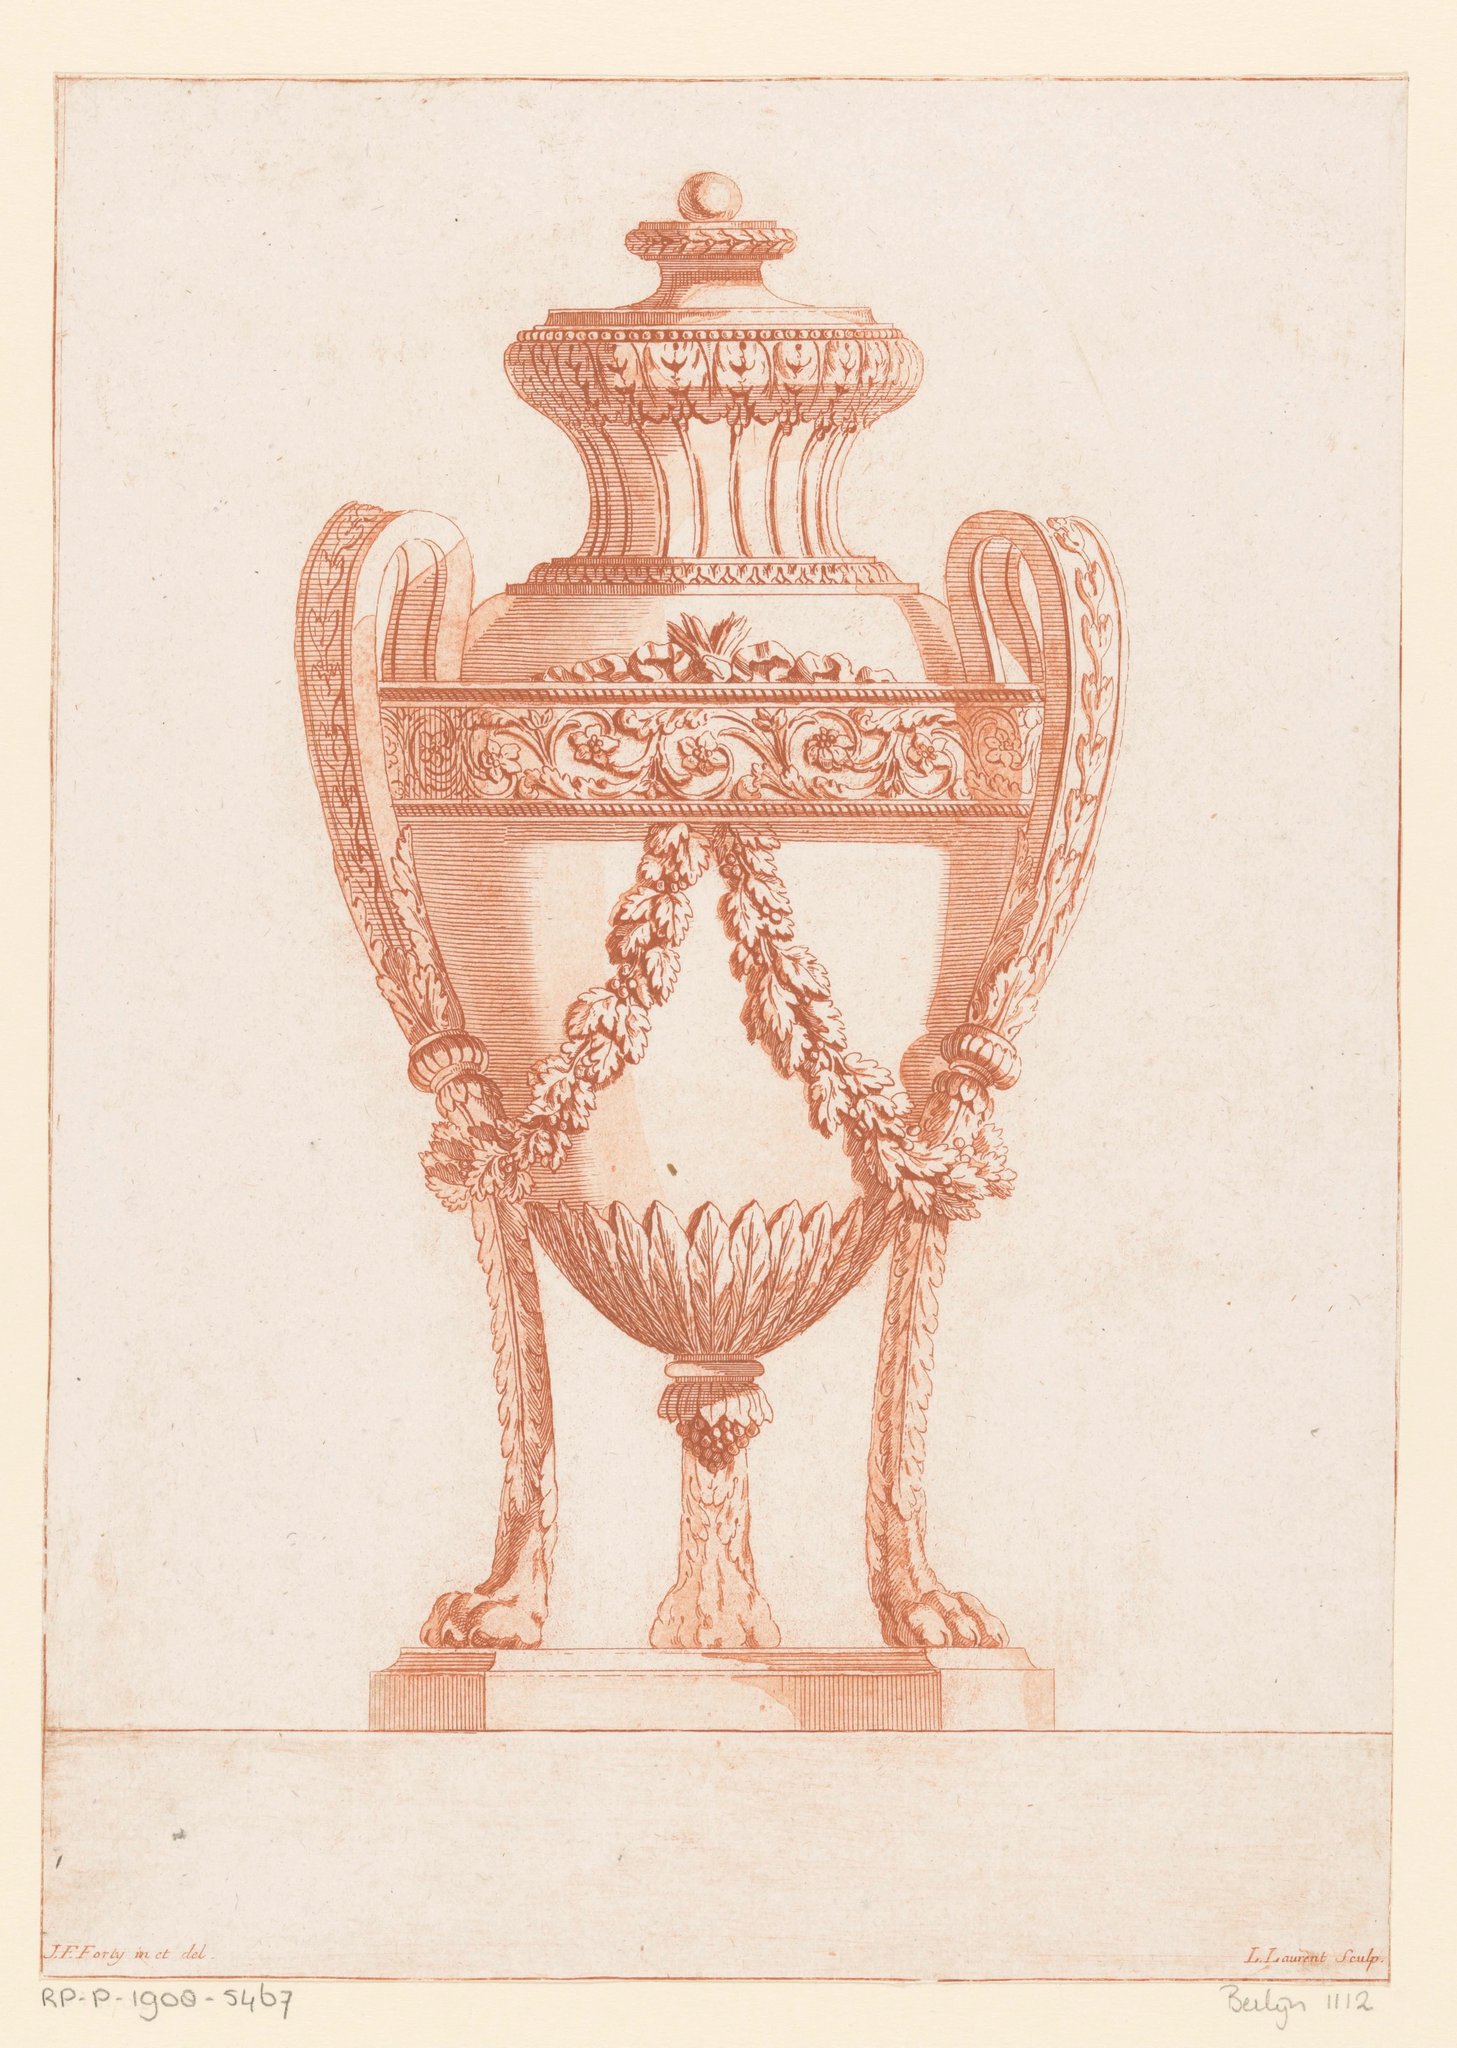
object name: ornament print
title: IIeme [IIIeme] Cahier de Vases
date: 1775-1785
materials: paper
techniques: engraving, etching, intaglio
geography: paris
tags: beasts of prey, predatory animals: lion (+ claws, paws of an animal), vase ~ ornament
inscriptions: collector's mark: Lugt 2228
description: Een geornamenteerde vaas met guirlandes, bloemmotieven en handvaten staand op drie leeuwenpoten.